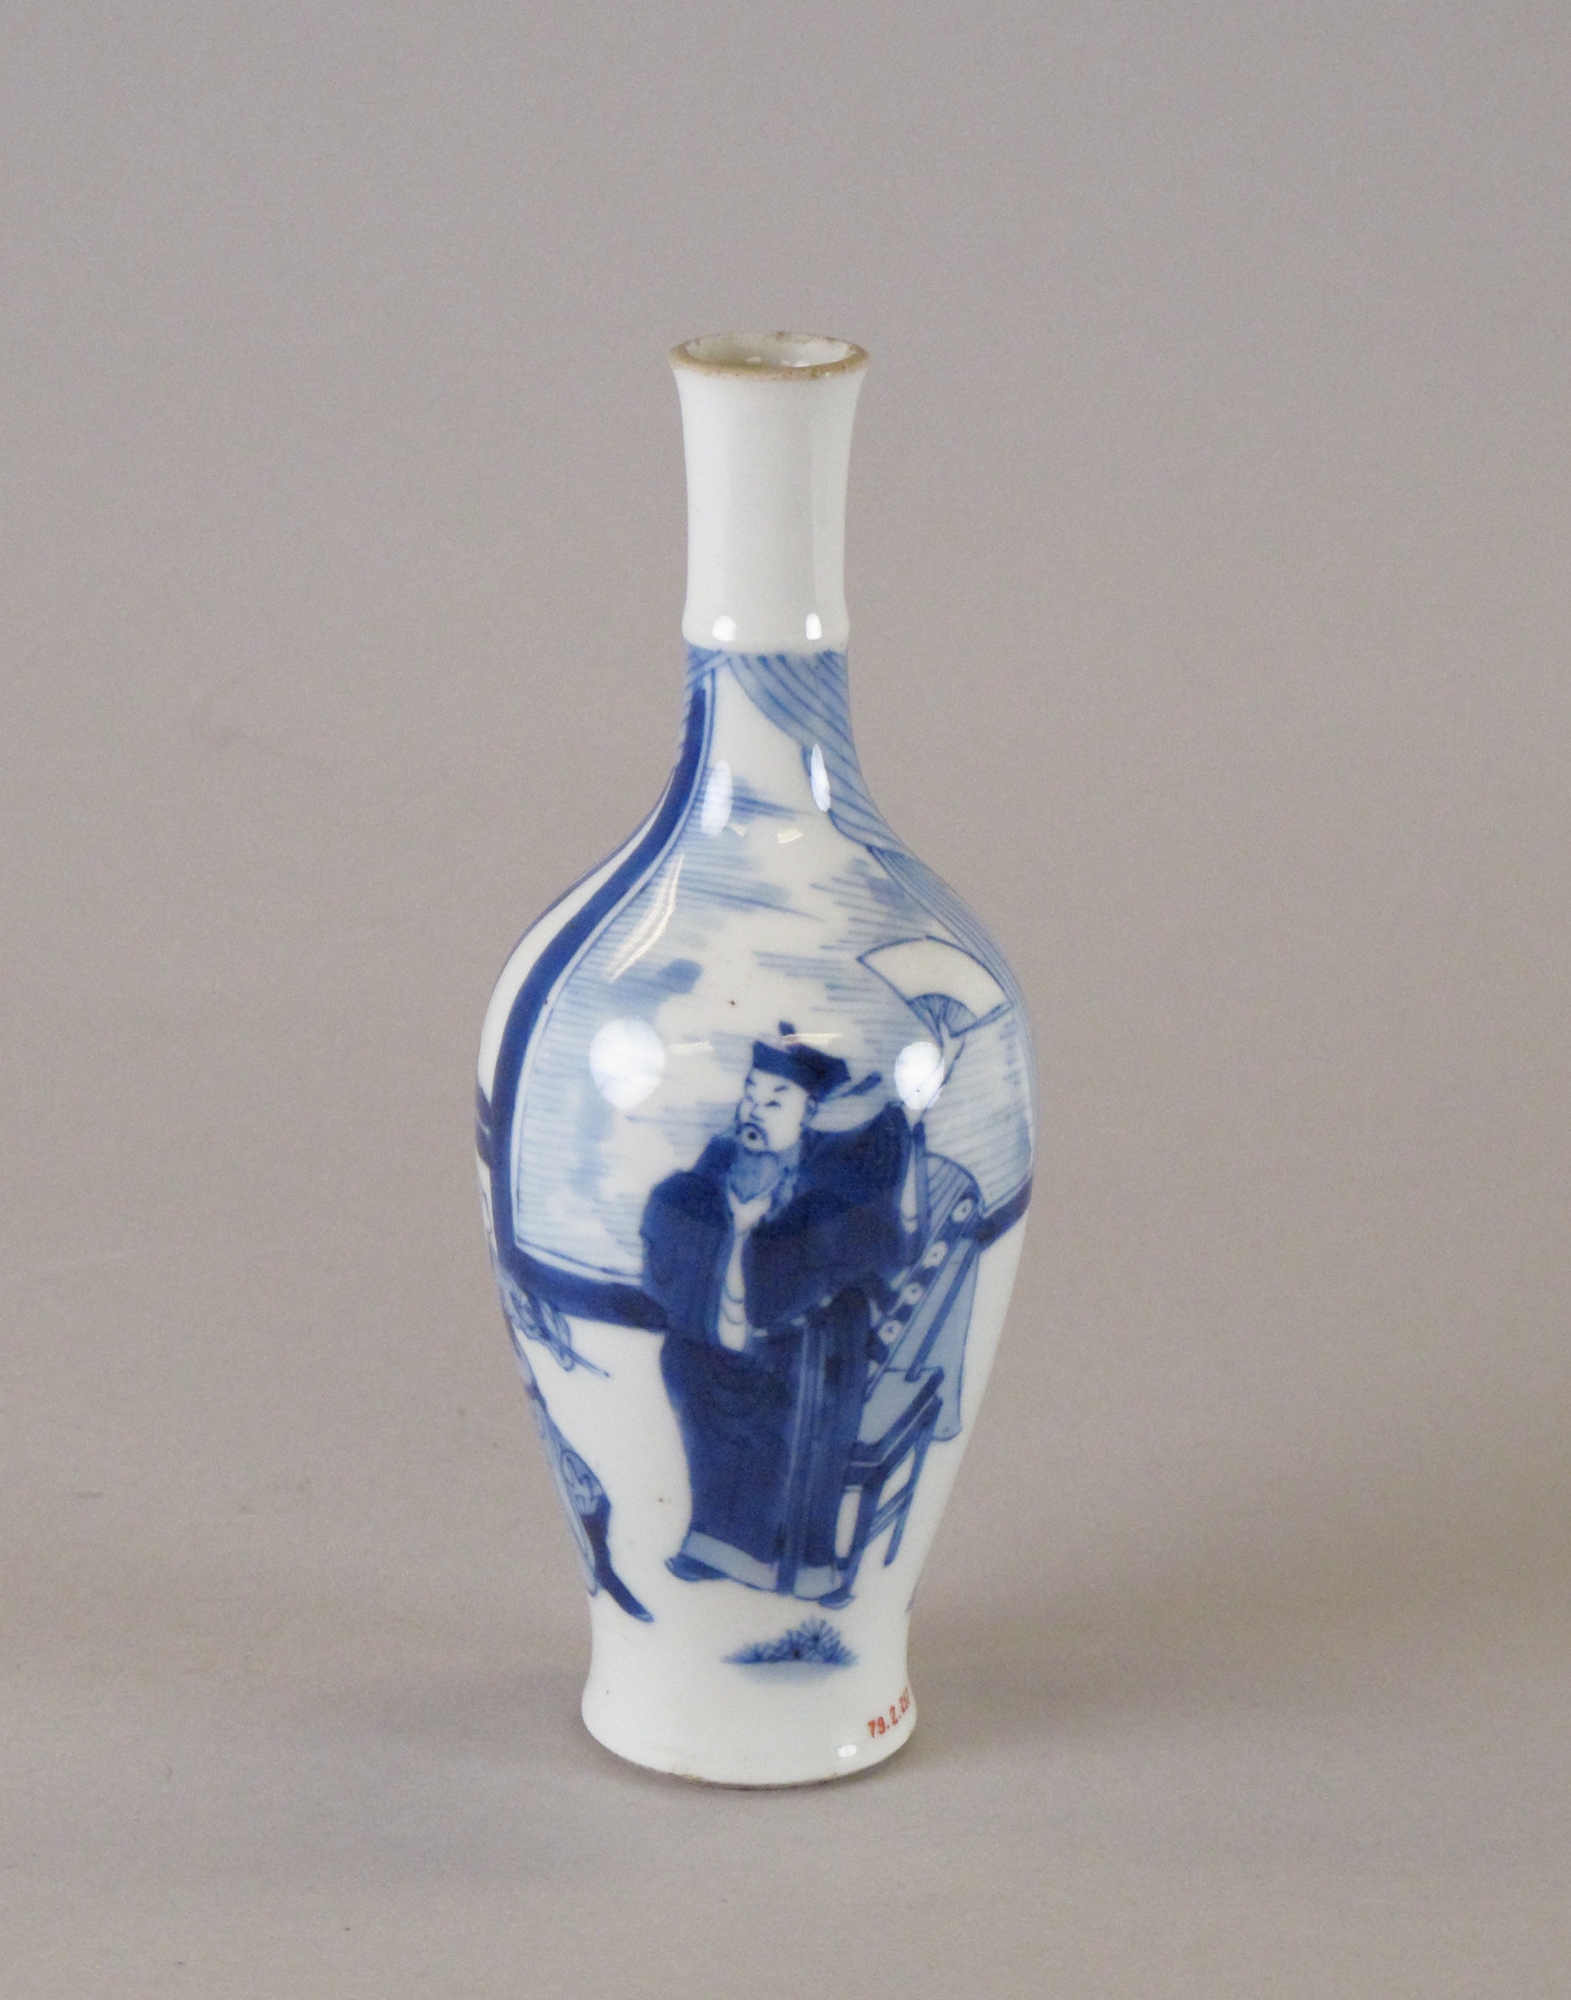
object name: vase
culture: chinese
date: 1644-1911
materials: porcelain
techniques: painting, underglaze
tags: fans,men